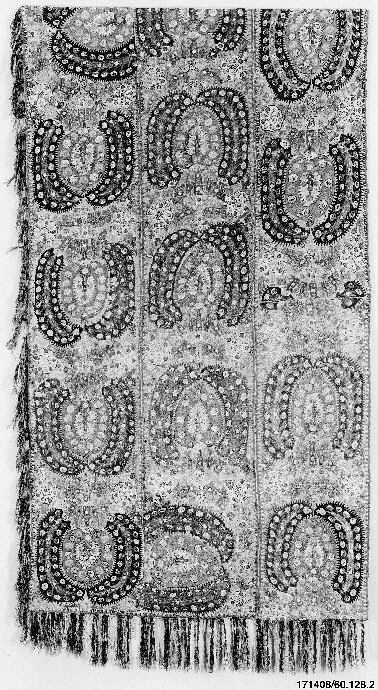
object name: hanging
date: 1701-1800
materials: linen, silk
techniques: embroidery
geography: greece